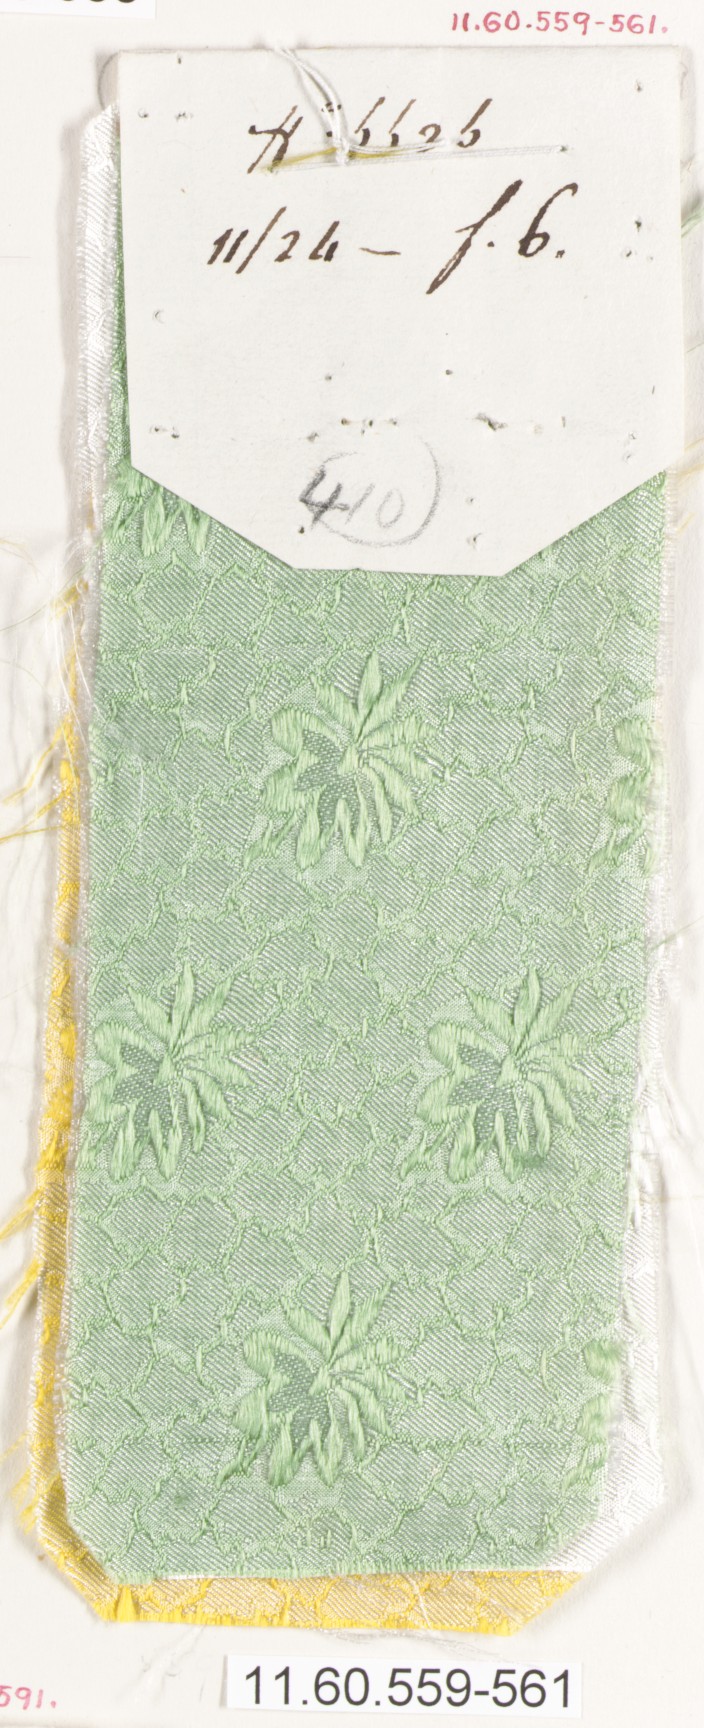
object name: sample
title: Samples (3)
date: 1801-1850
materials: silk